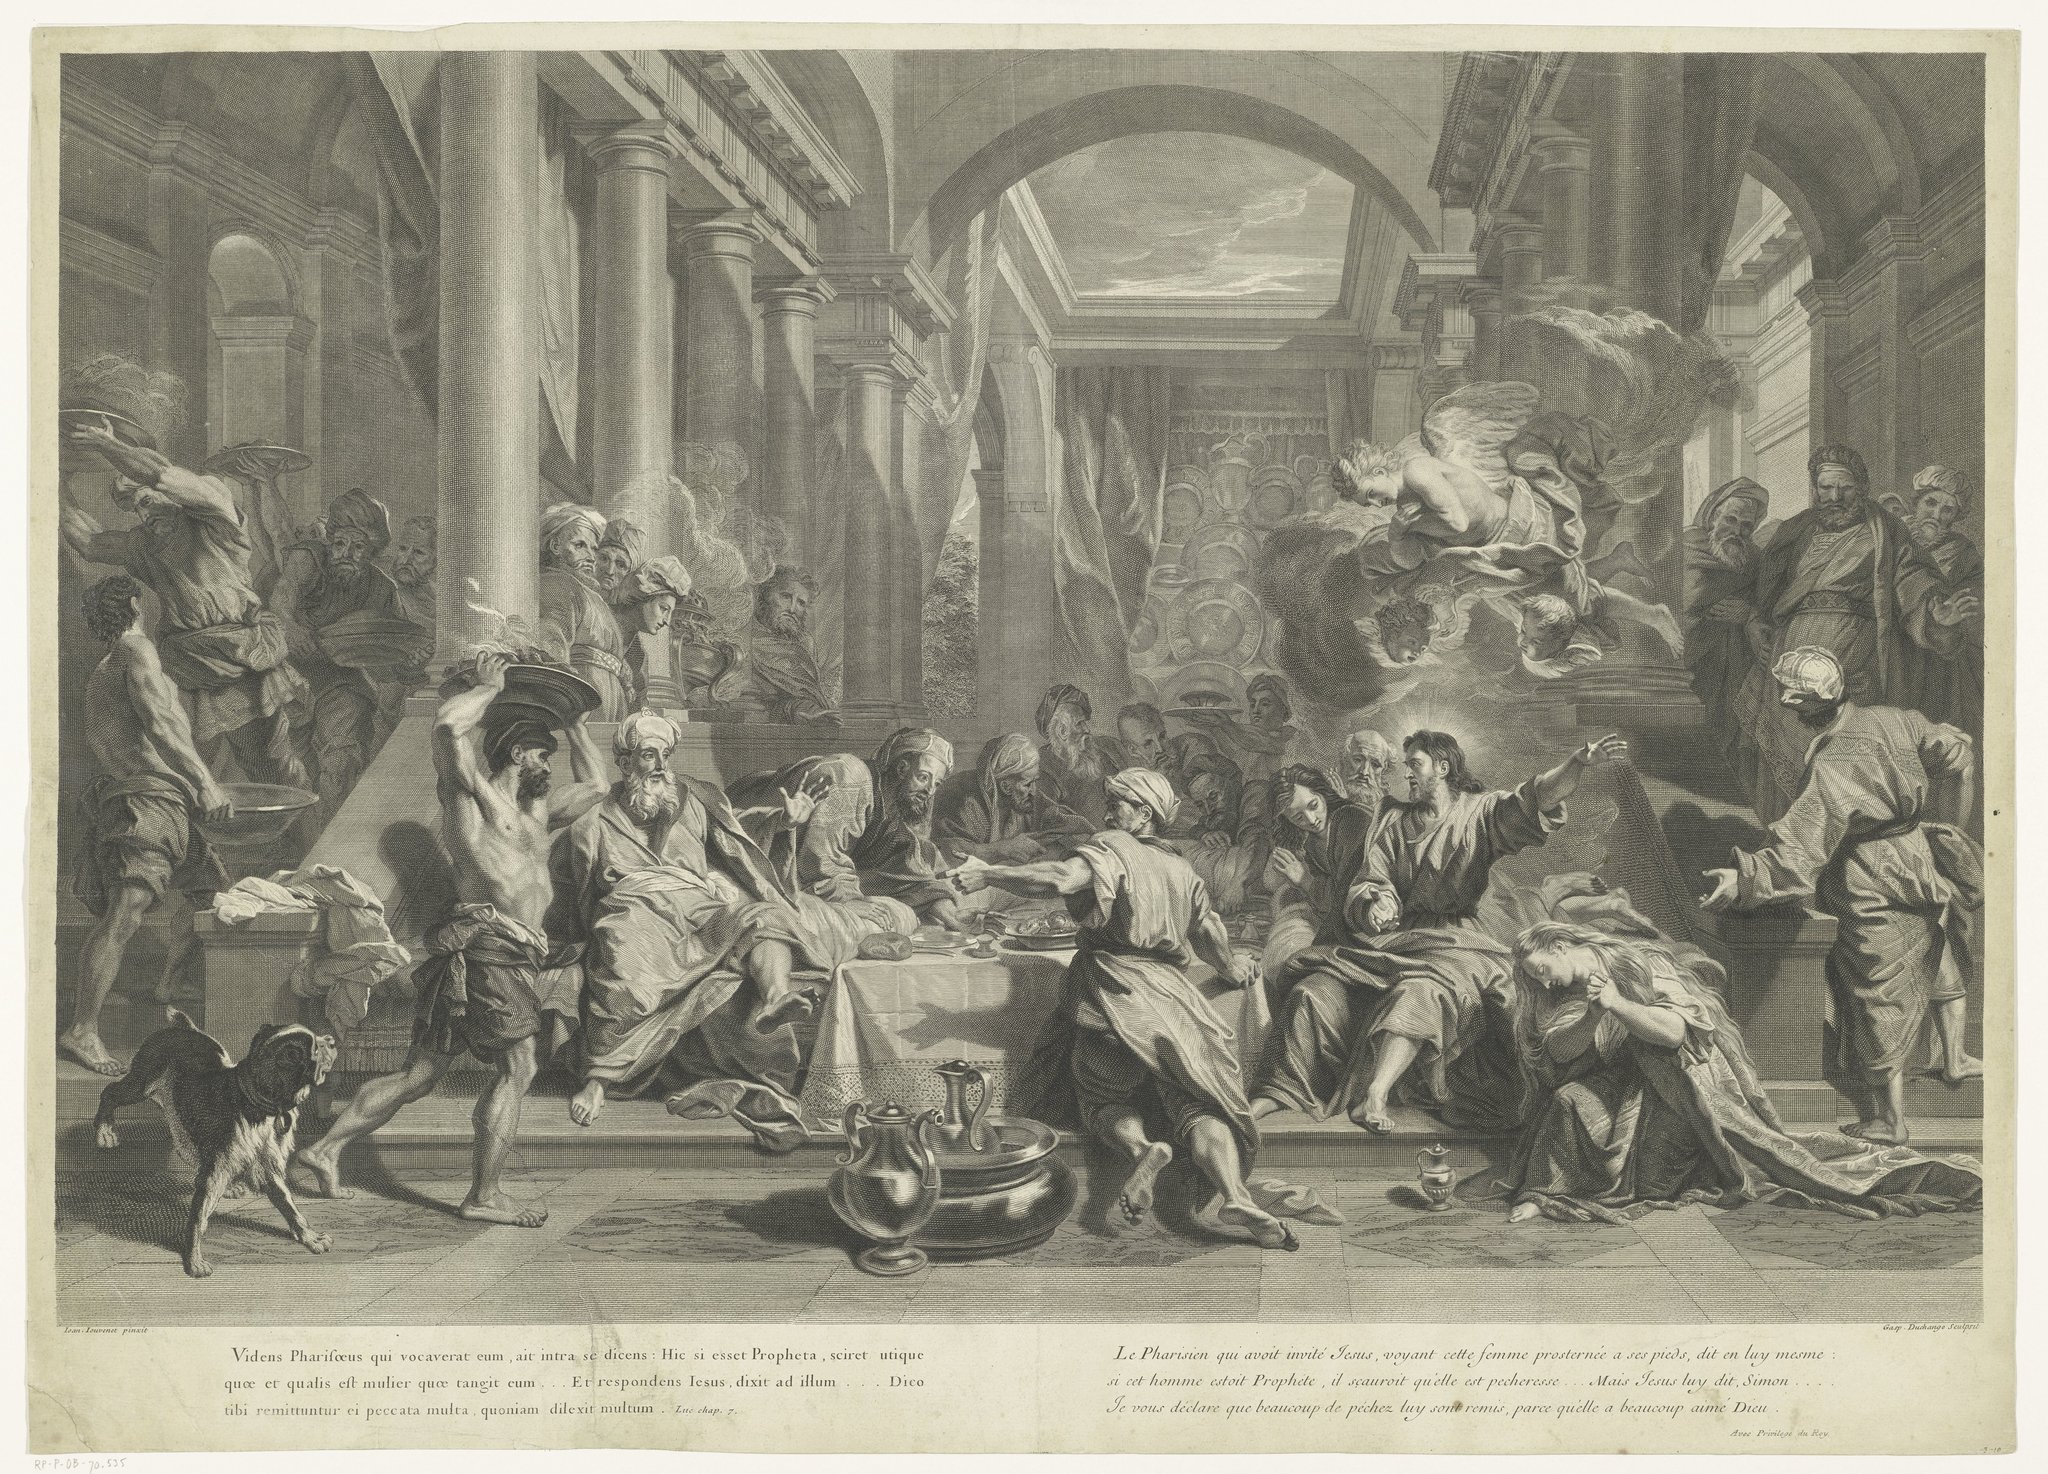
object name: print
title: Christus in het huis van Simon de Farizeeër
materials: paper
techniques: engraving, etching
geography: france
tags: meal at the house of simon the pharisee (luke 7:36-50)